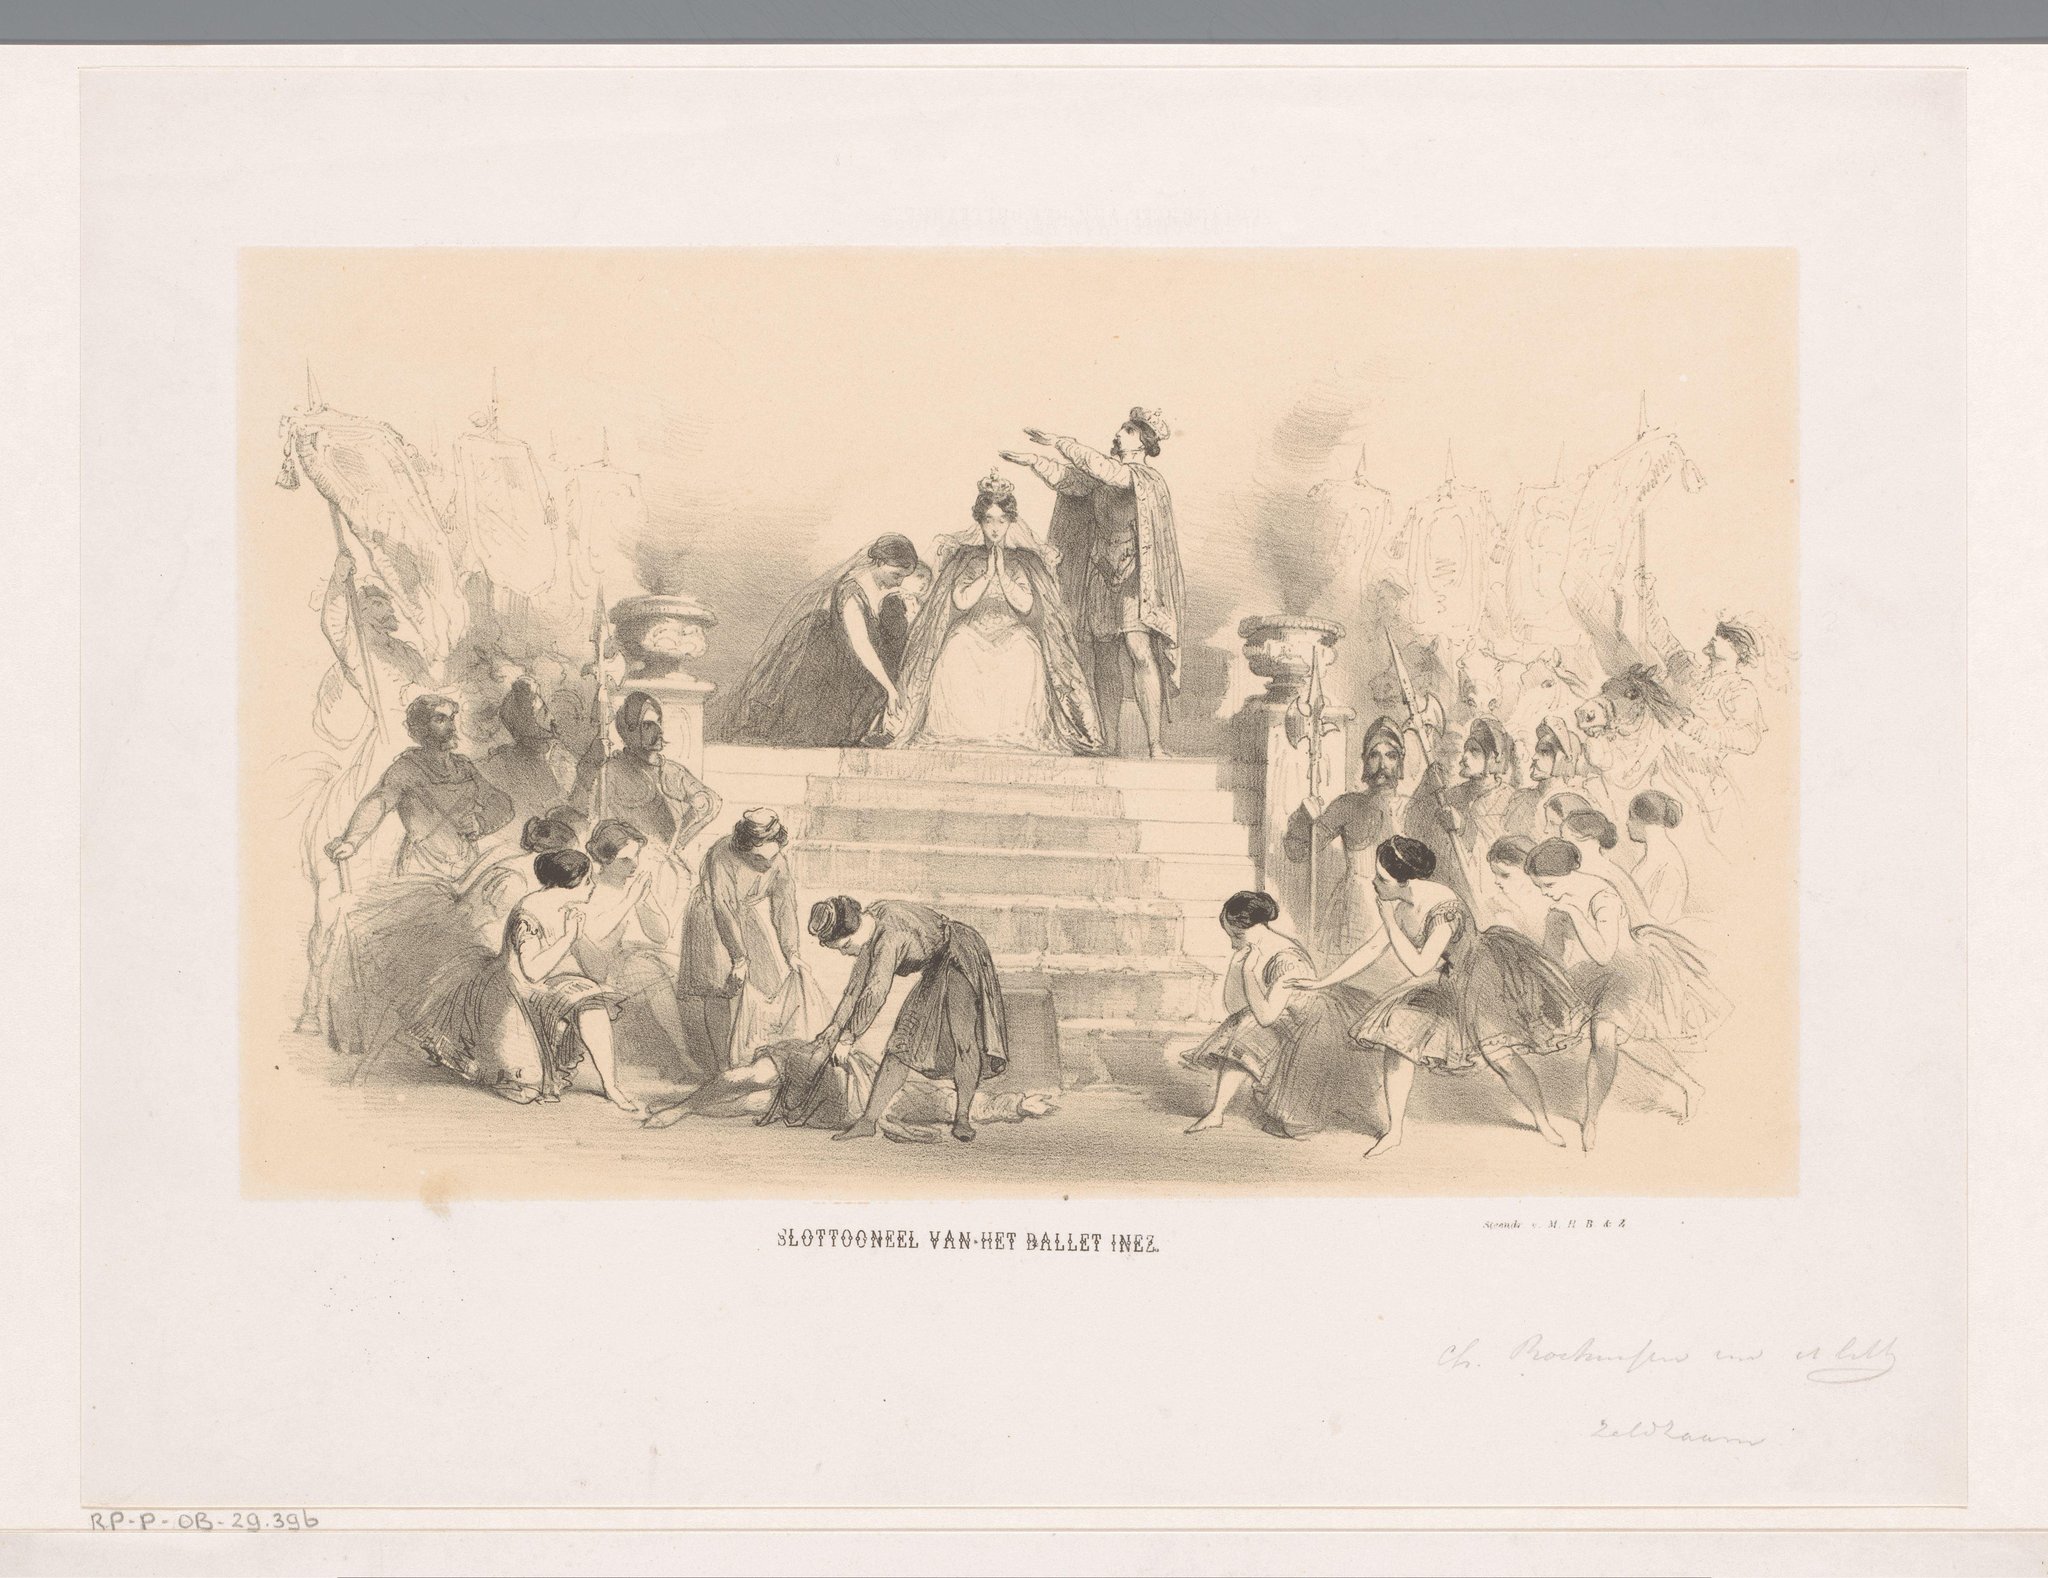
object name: print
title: Kroning van Inês de Castro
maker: charles rochussen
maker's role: draughtsman, painter, print maker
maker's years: 1814-1894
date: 1850-1857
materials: paper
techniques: tone lithography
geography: amsterdam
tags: coronation of a ruler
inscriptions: collector's mark: Lugt 2228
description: Scène uit een toneelstuk over het leven van Inês de Castro, minnares van Peter van Portugal. Inês wordt gekroond door de koning. Rondom zitten knielende figuren.